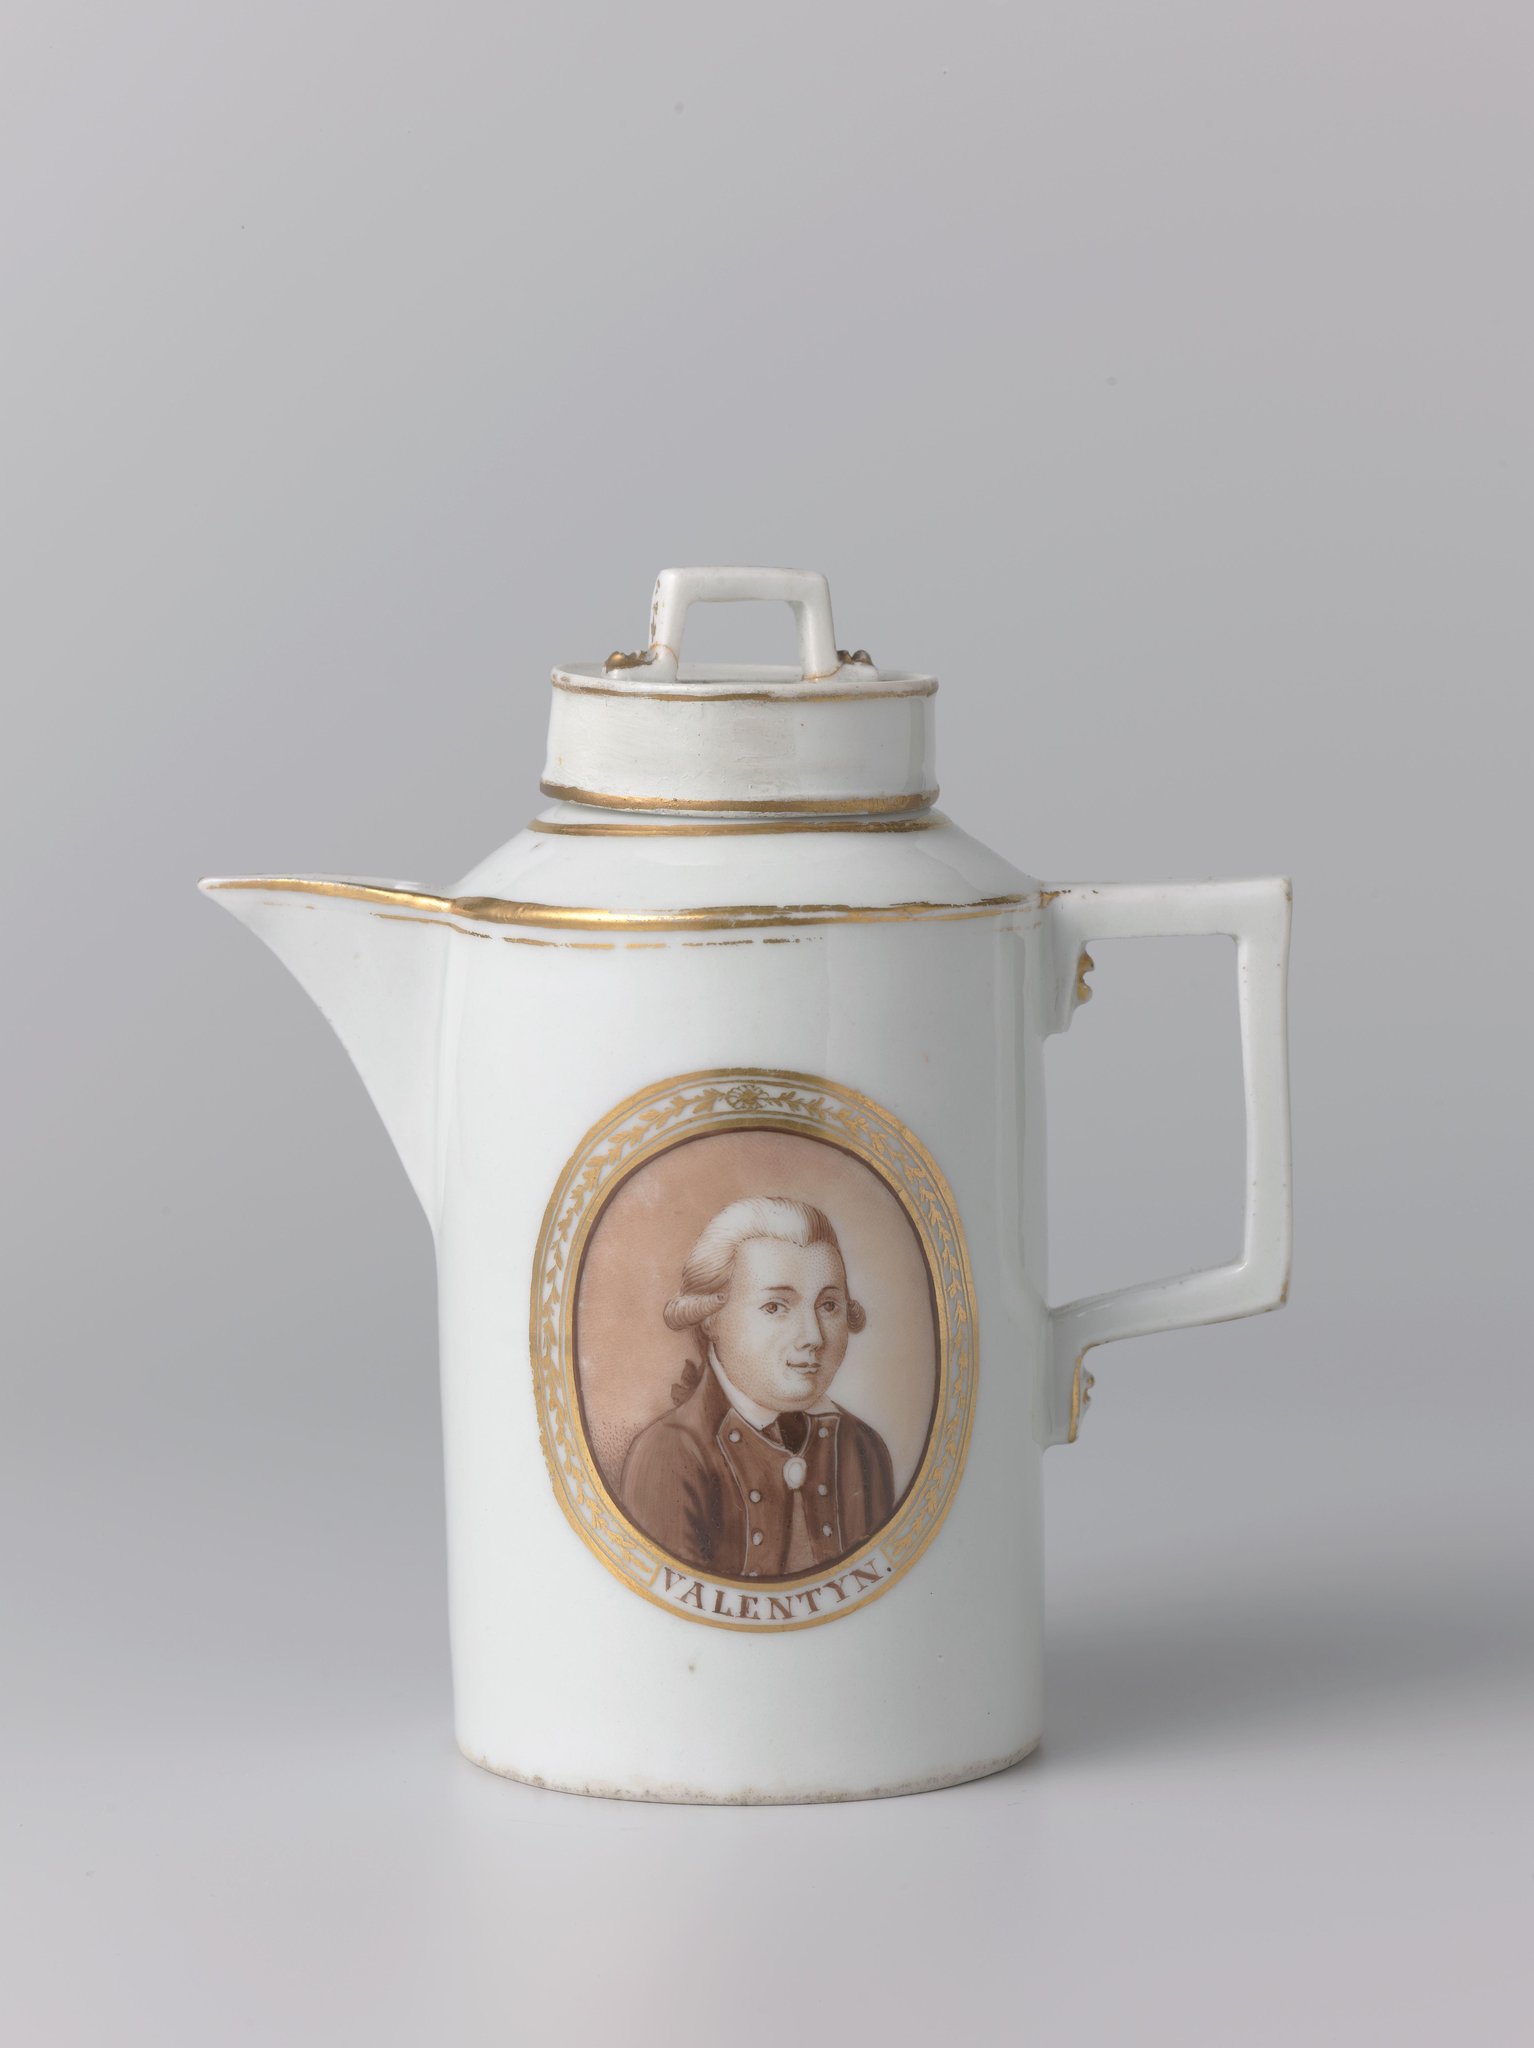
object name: lid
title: Cover of a milk jug with gold lines and a foliate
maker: Anonymous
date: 1794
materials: glaze, gold, paint, porcelain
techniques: firing, forming, gilding, turning, vitrification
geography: amsterdam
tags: kapitein, abraham valentijn, kattenburg, inname van kattenburg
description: Deksel van melkkan van porselein, onderdeel van een servies met in bruin geschilderde medaillons waarin historische voorvallen en portretten van personen uit de vaderlandse geschiedenis. Gouden biezen en een takje op de dekselknop.